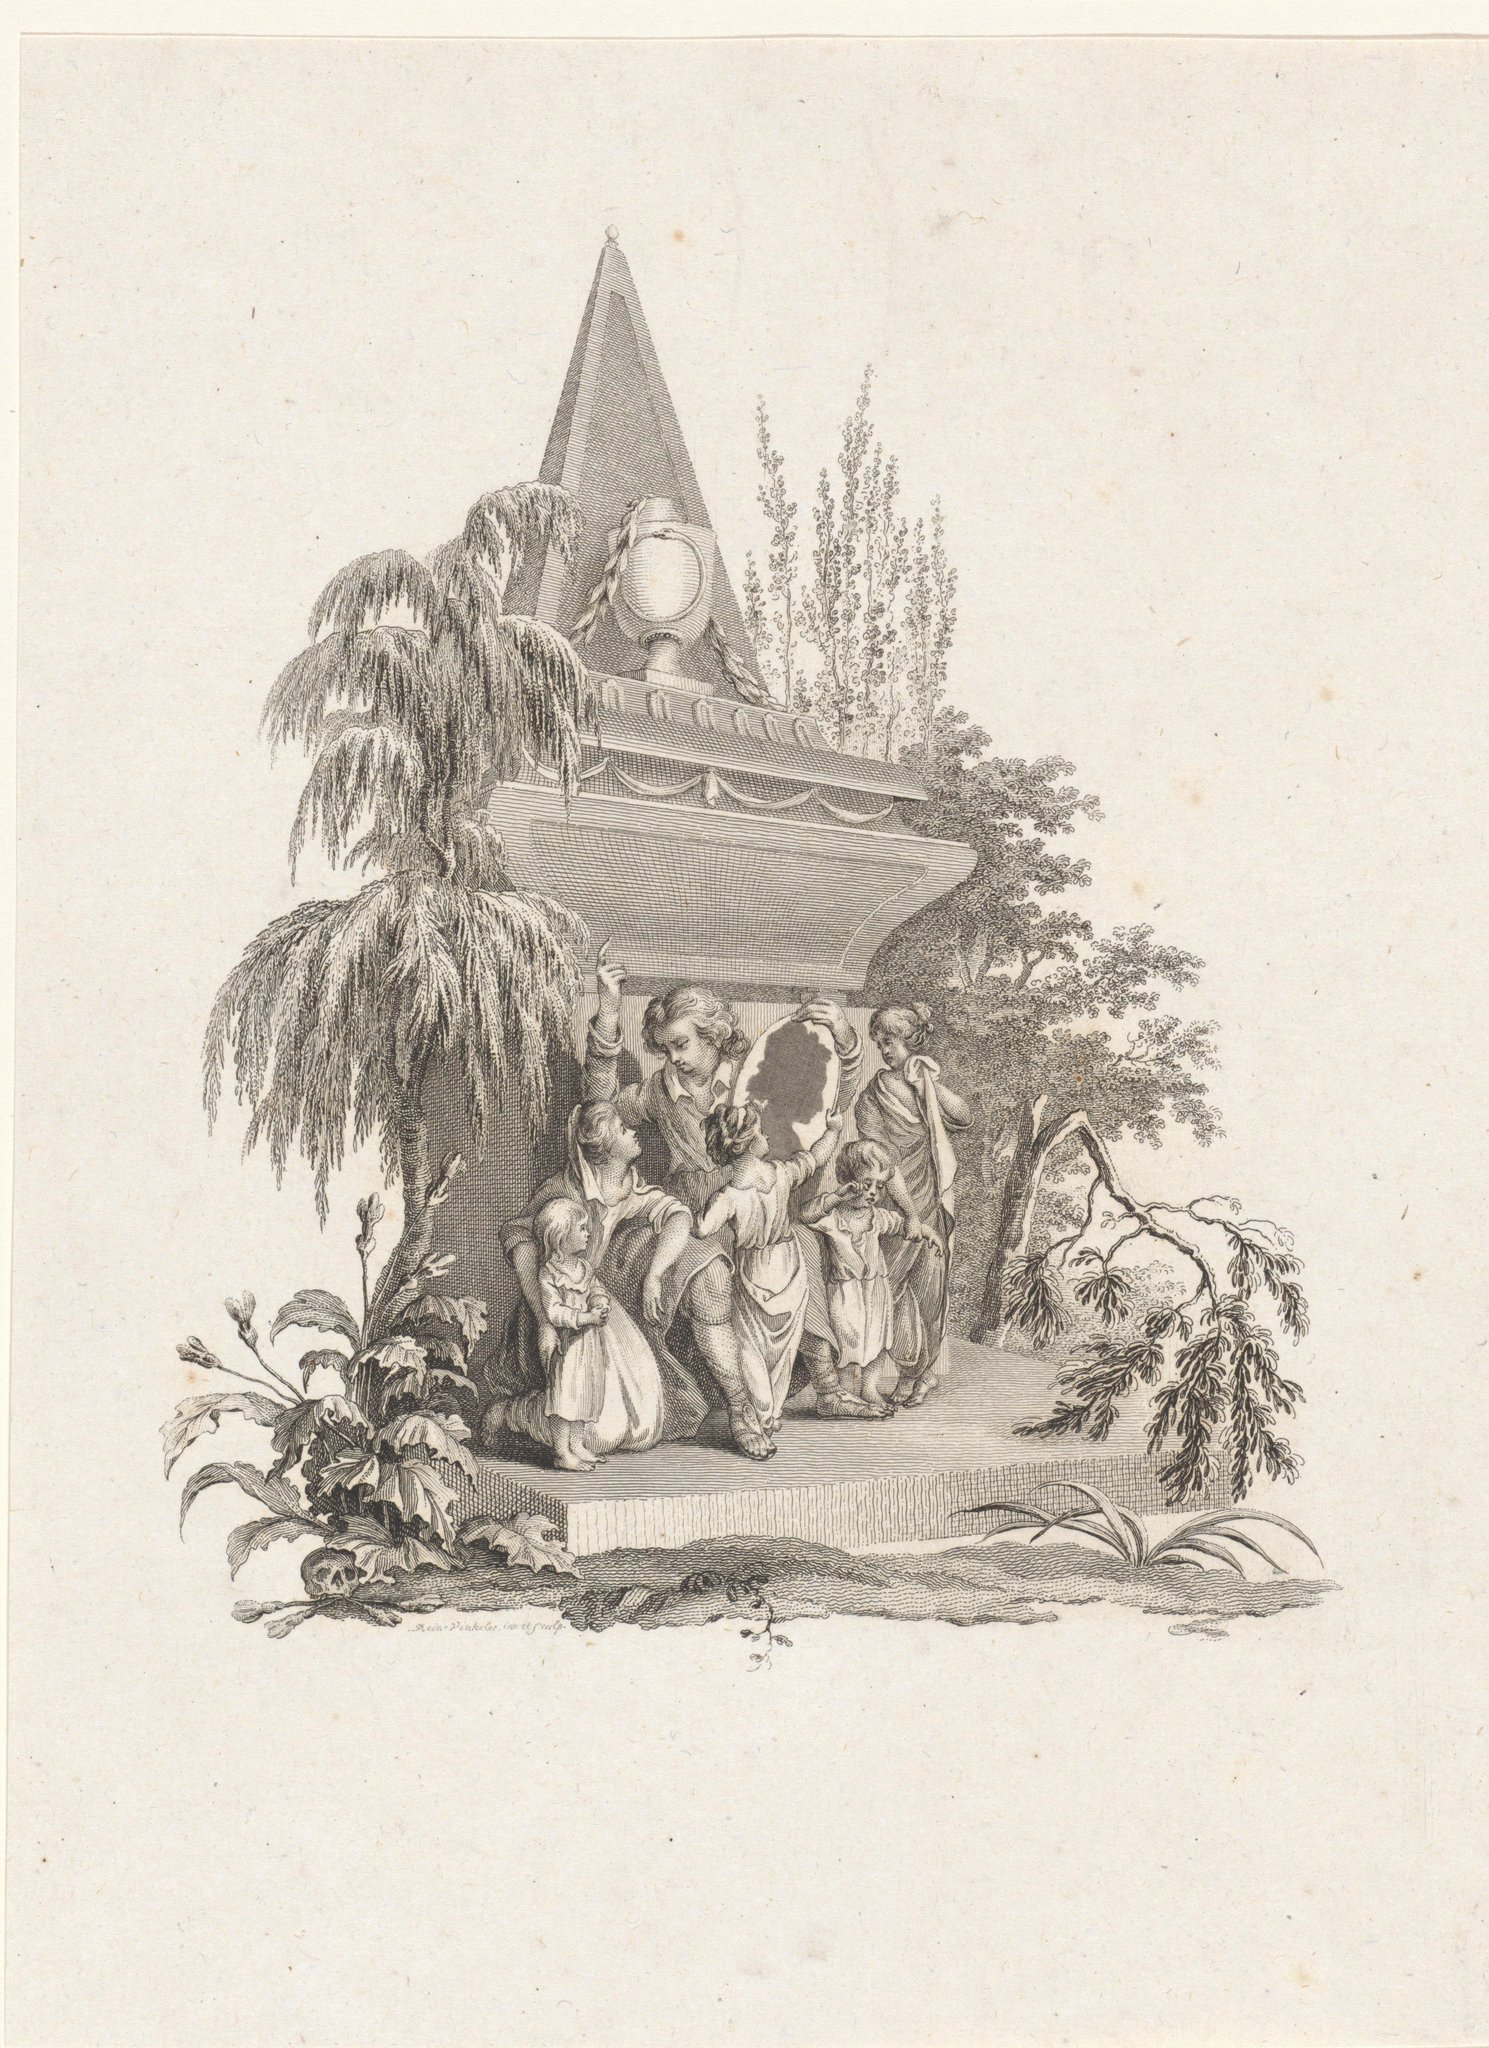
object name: print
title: Grafmonument voor een overleden vrouw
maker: reinier vinkeles (i)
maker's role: draughtsman, print maker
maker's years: 1741-1816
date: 1795-1797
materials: paper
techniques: engraving, etching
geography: amsterdam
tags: index finger upwards, grave-building, monumental tomb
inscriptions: collector's mark: Lugt 2228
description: Grafmonument voor een overleden vrouw (J.Rikkengha?). Een man, met een medaillon met een silhouetportret van een vrouw, zit voor een grafmonument en is omringd door vijf kinderen. Hij wijst naar boven.